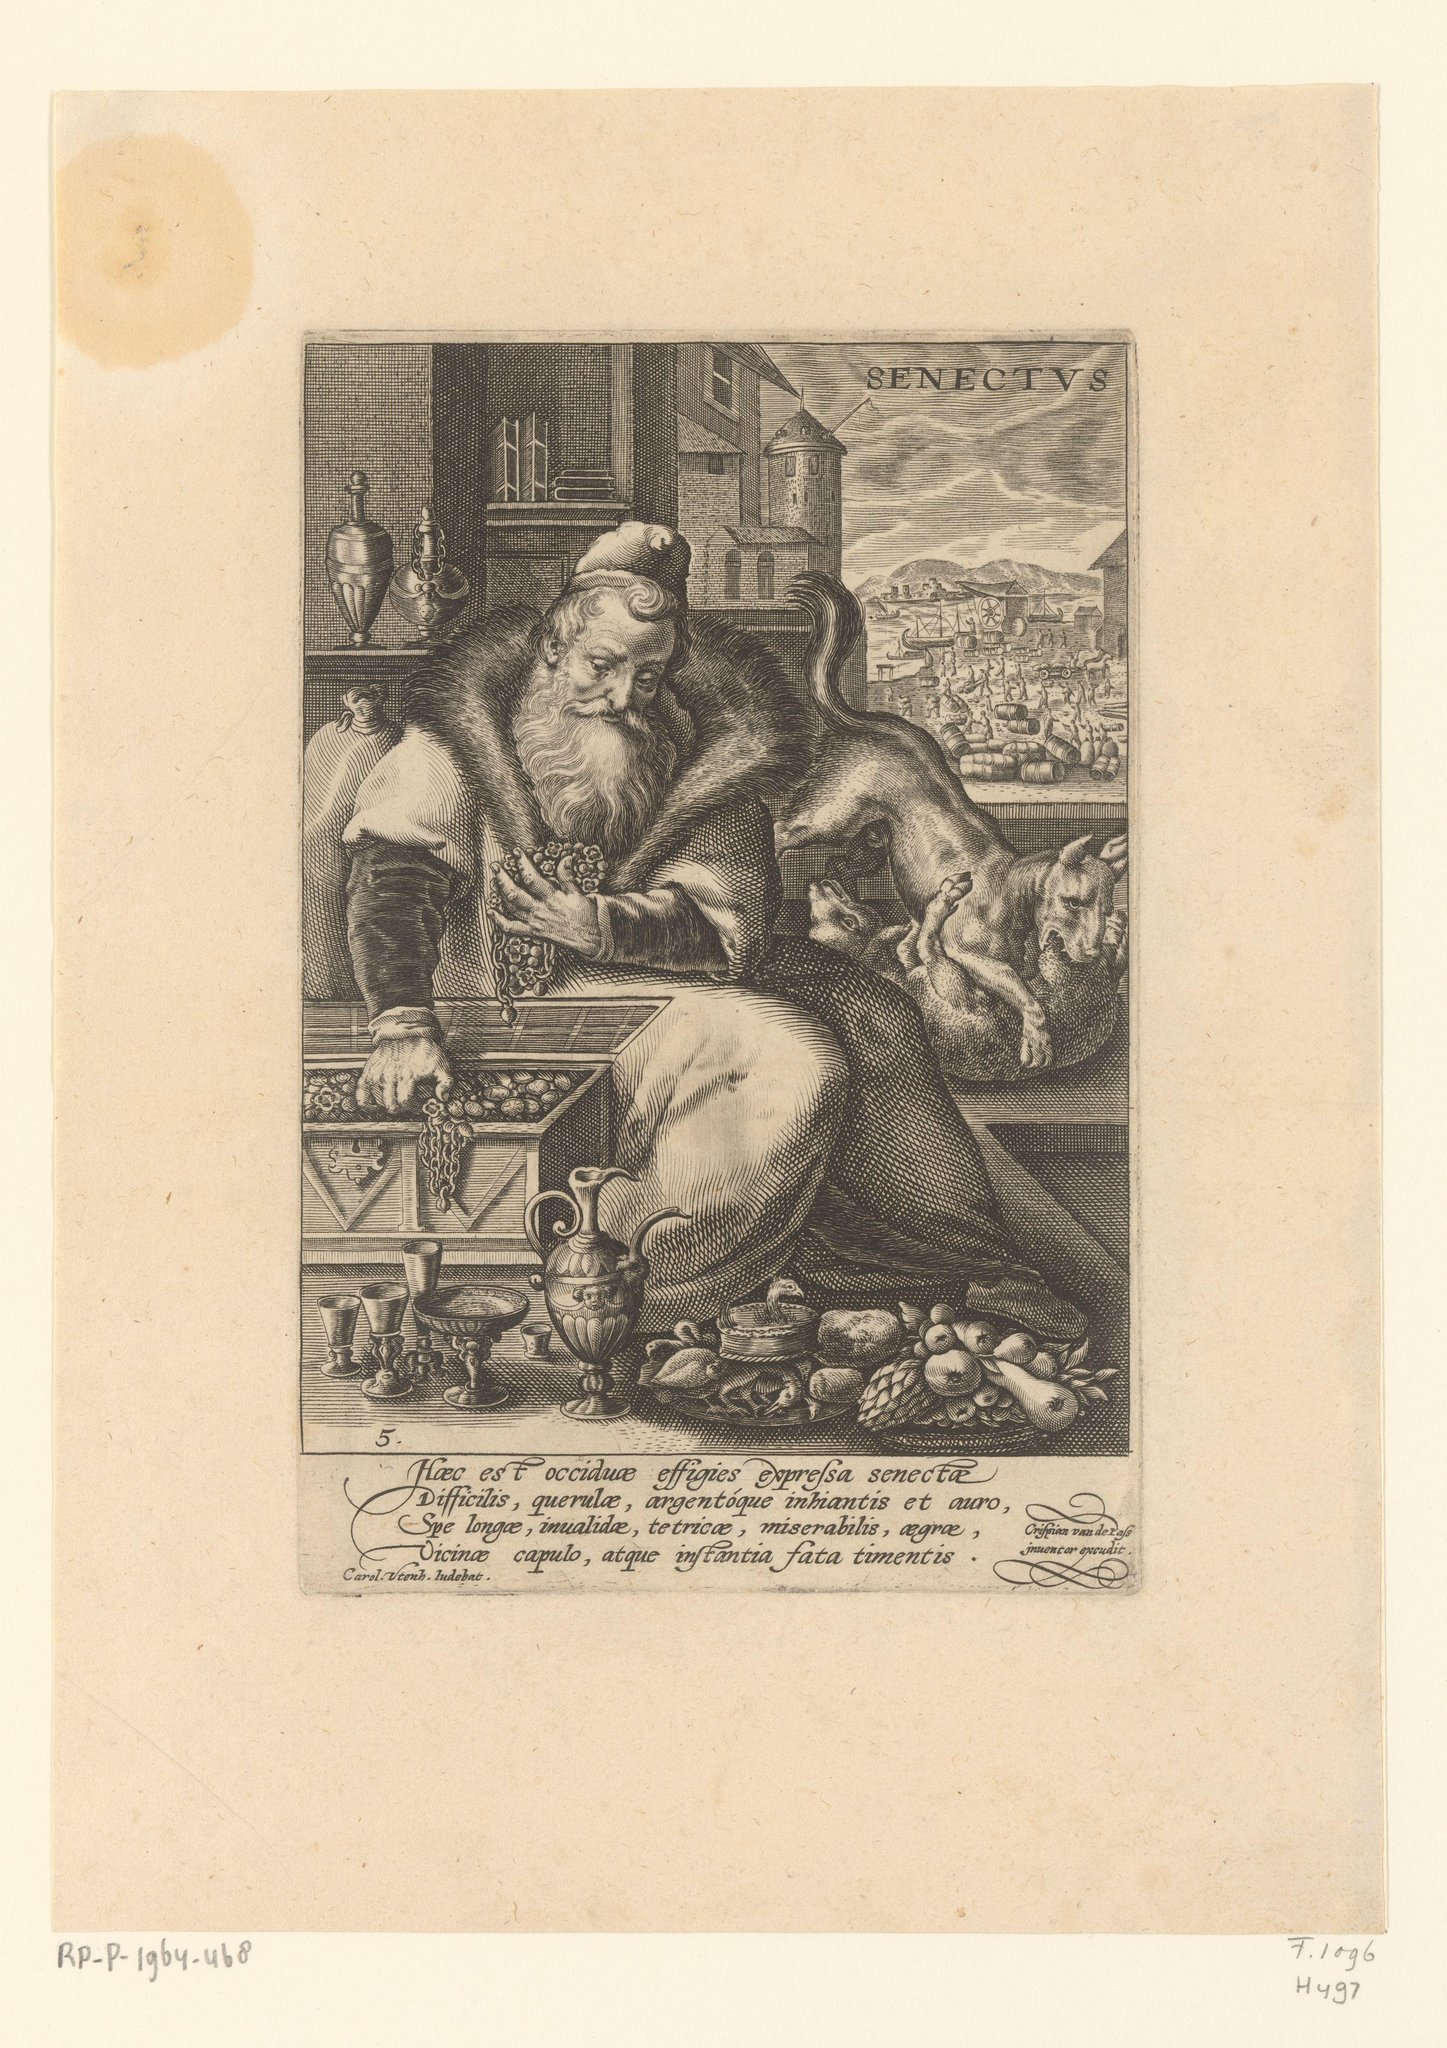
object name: print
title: Ouderdom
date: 1599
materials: paper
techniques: engraving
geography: cologne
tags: old age, 'senectus'; 'vecchiezza' (ripa), beasts of prey, predatory animals: wolf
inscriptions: collector's mark: Lugt 2228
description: Vertrek met een hebzuchtige oude man die in een kist met geld en sieraden graait. Achter hem valt een wolf (symbool voor hebzucht) een lam aan. Op de achtergrond een bedrijvige haven. In de marge een vierregelig onderschrift in het Latijn.